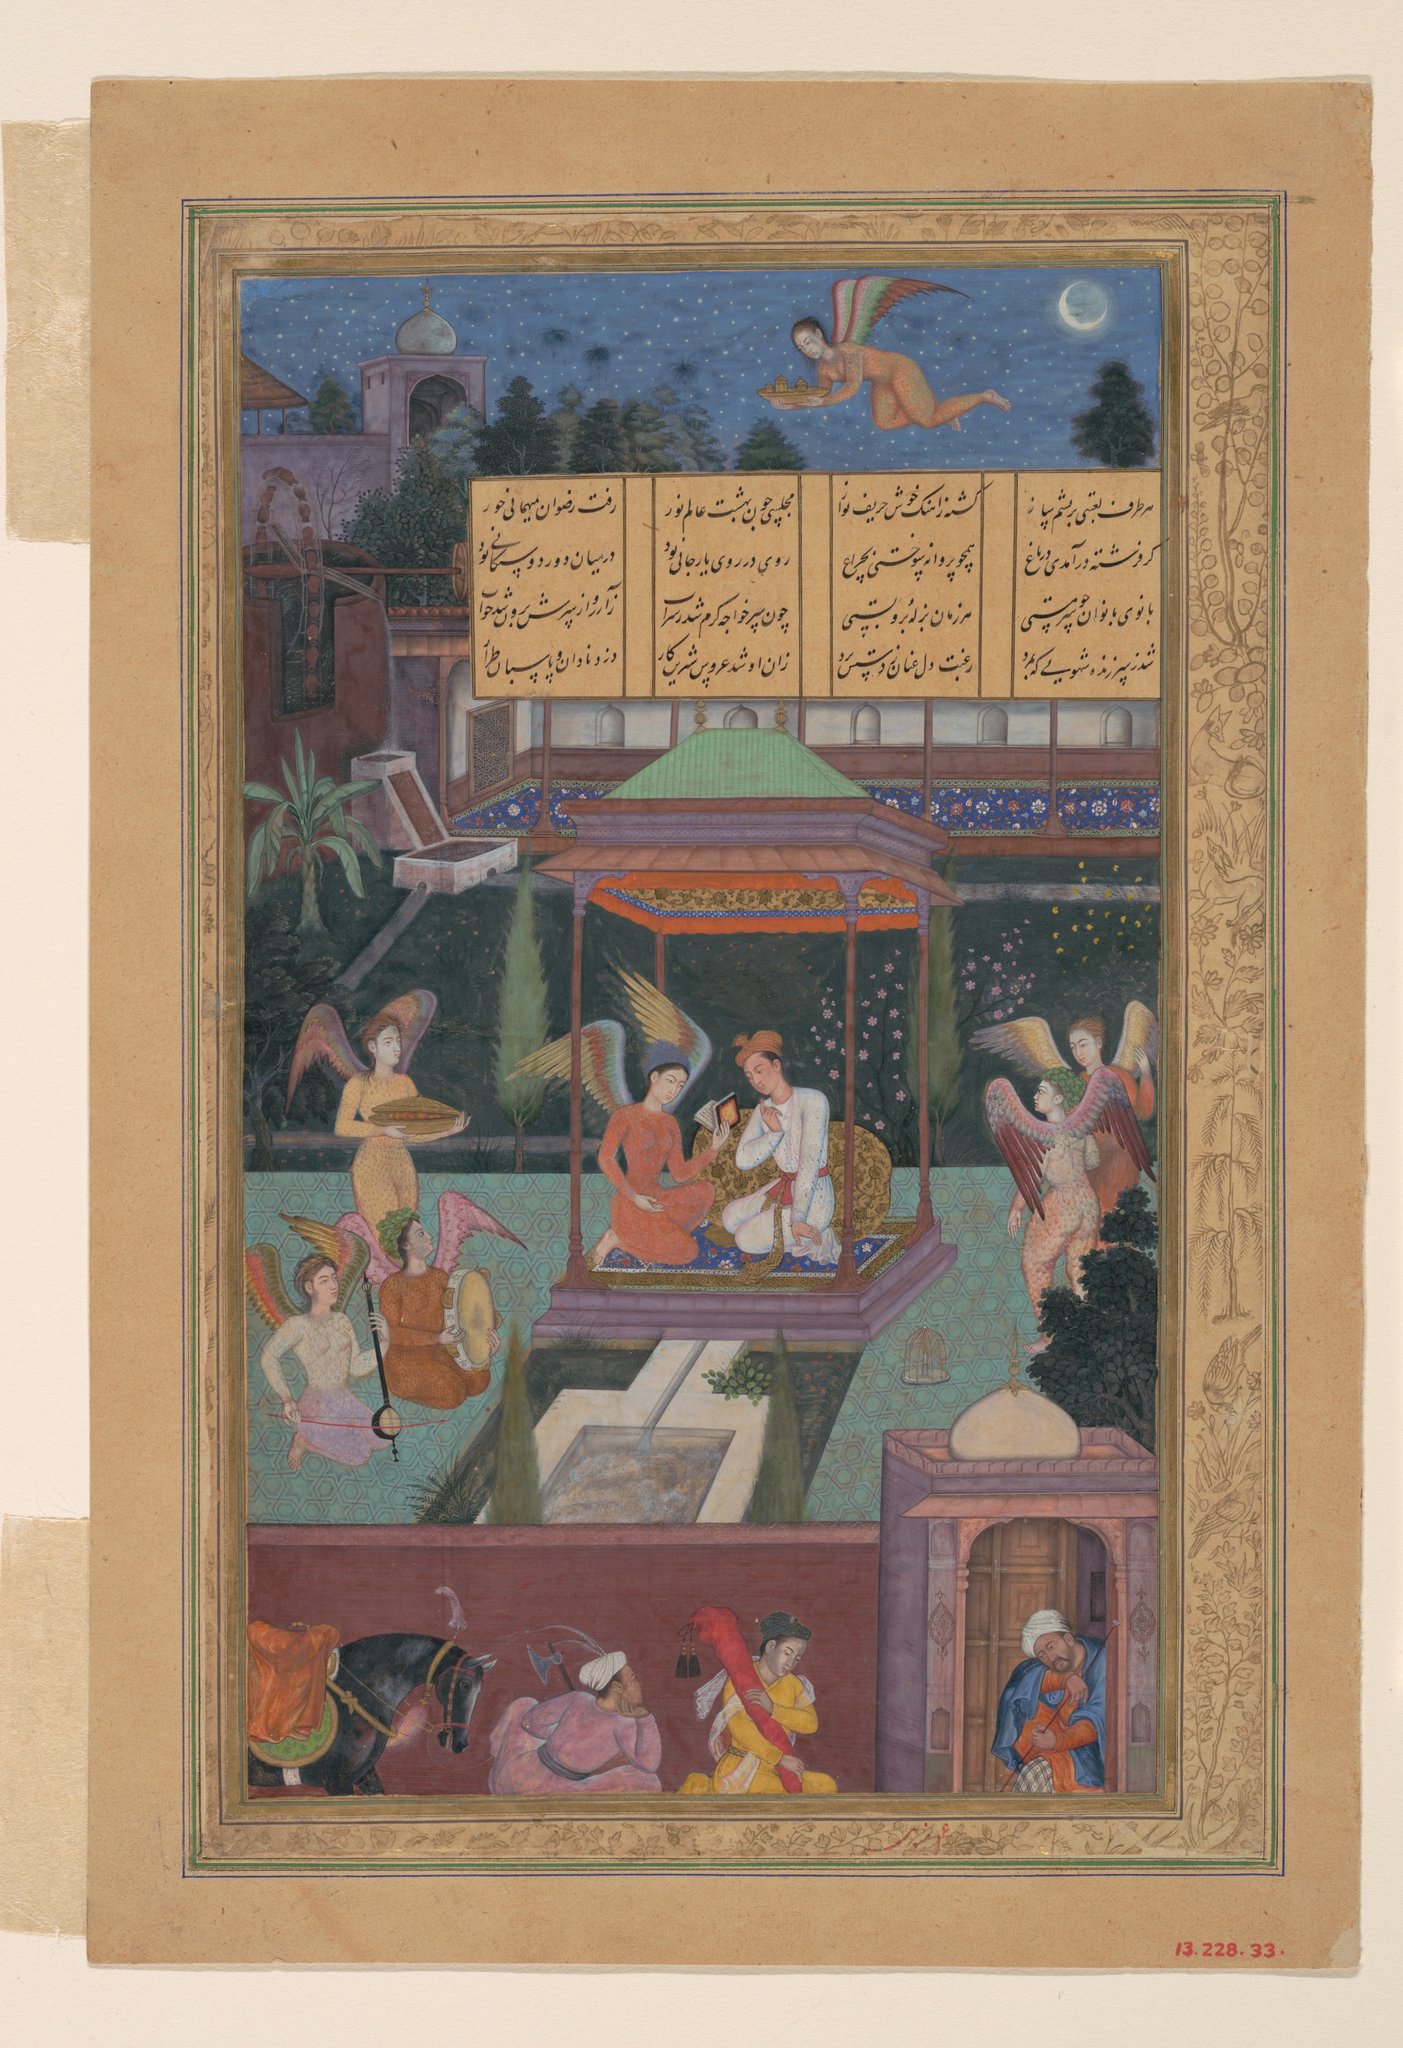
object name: folio from an illustrated manuscript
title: "The Story of the Princess of the Blue Pavillion: The Youth of Rum Is Entertained in a Garden by a Fairy and her Maidens", Folio from a Khamsa (Quintet) of Amir Khusrau Dihlavi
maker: amir khusrau dihlavi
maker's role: author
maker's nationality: indian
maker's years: 1228-1350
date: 1597-1598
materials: gold, ink, paper, watercolor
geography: india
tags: musical instruments,gardens,men,reading,fairies,horses,musicians